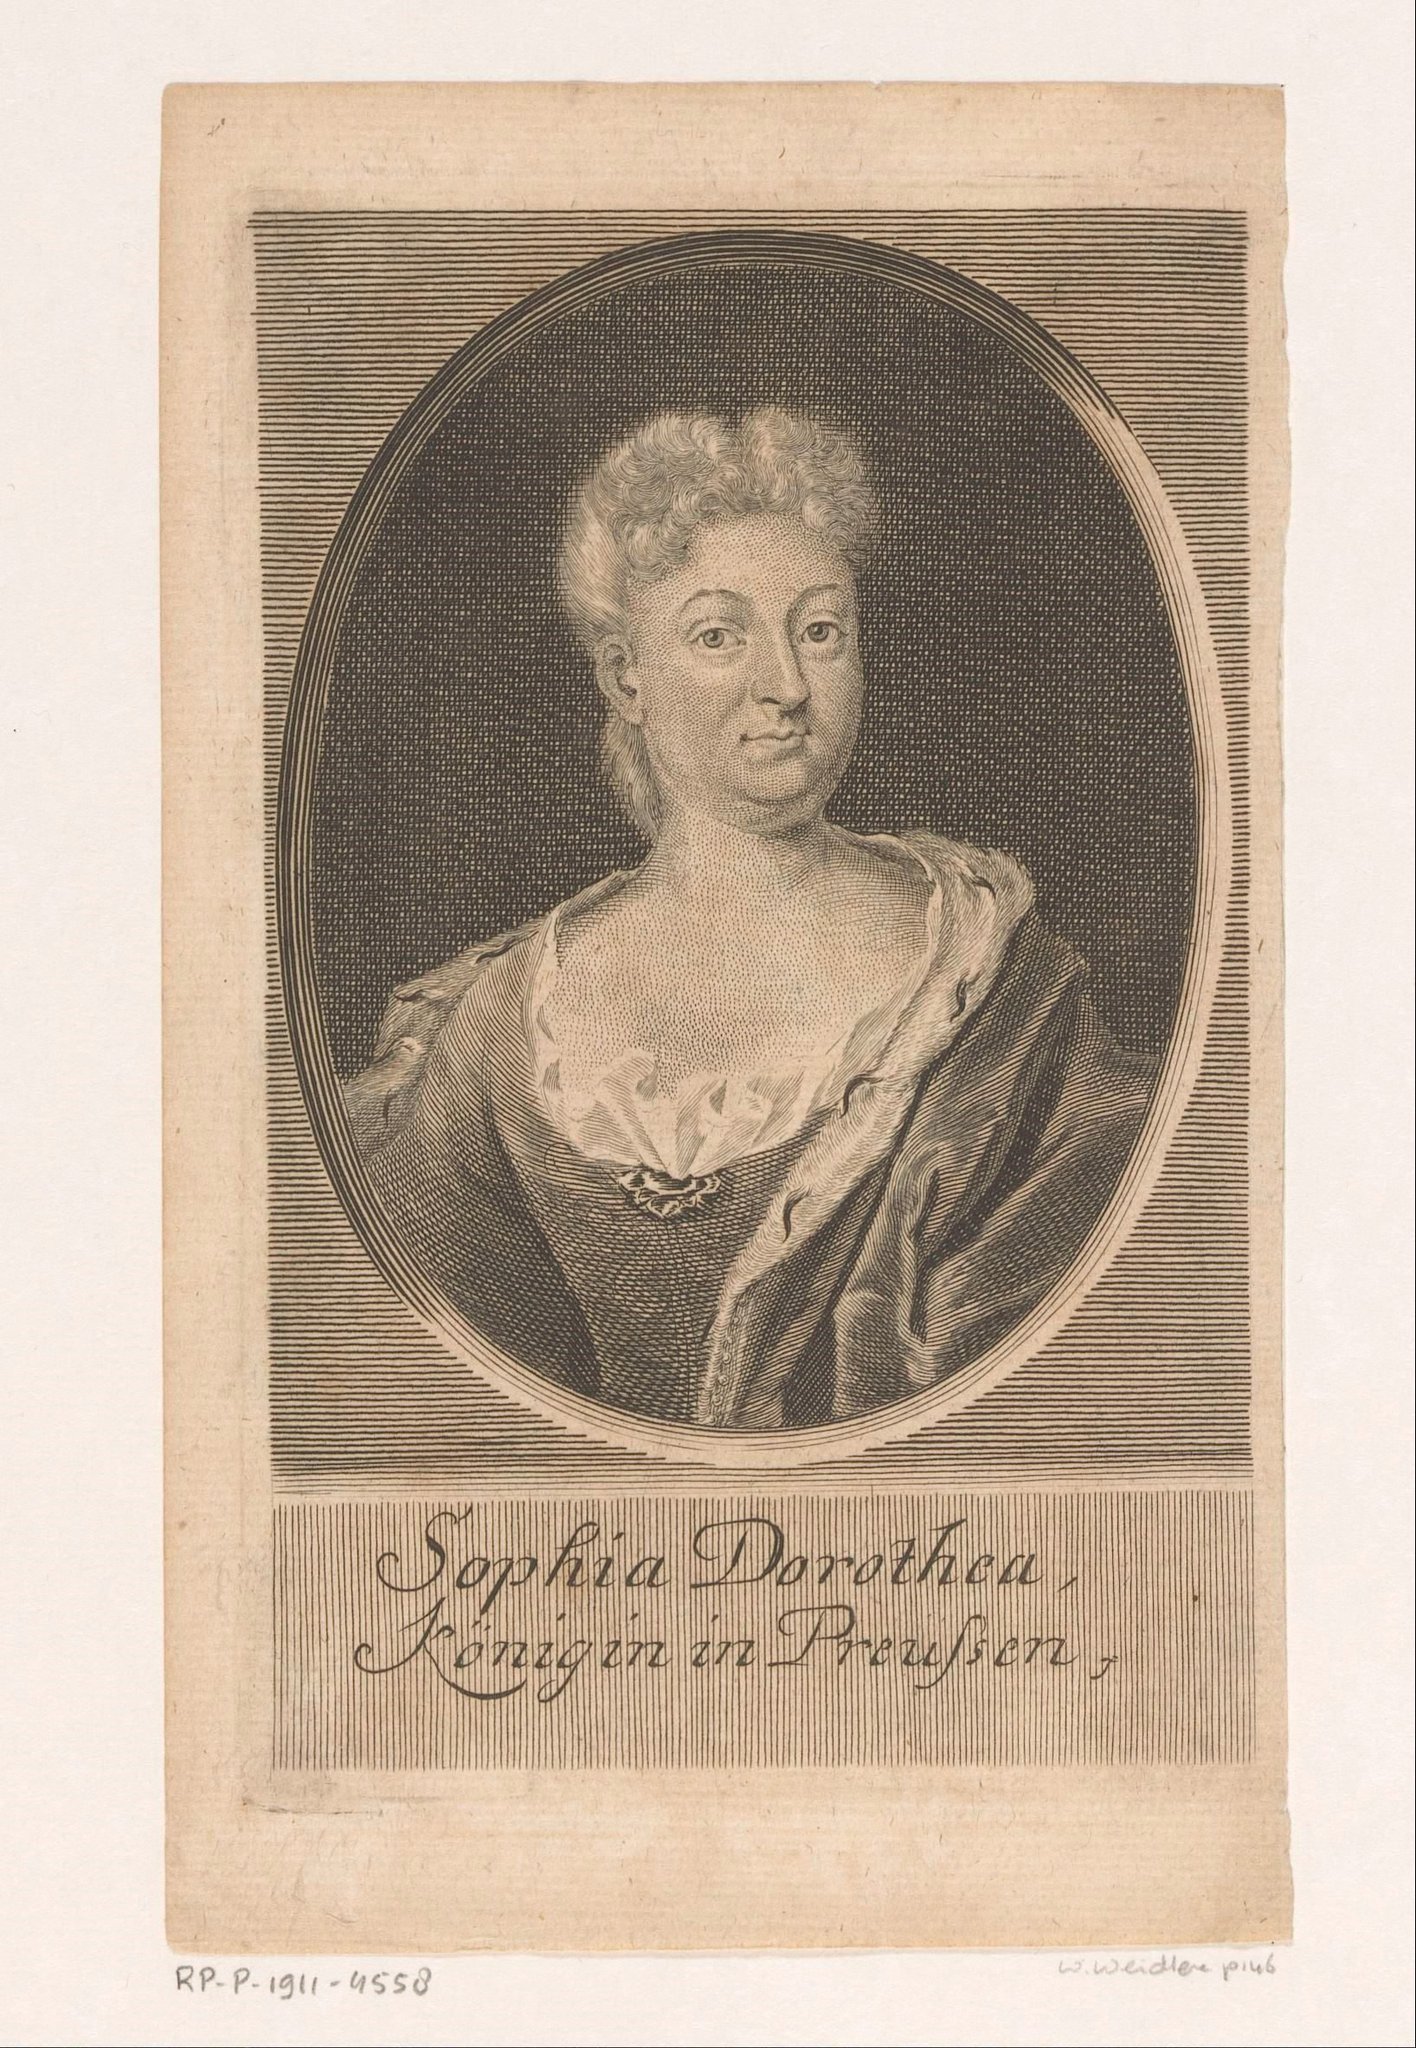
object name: print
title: Portret van Sophia Dorothea, koningin van Pruisen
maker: martin bernigeroth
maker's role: print maker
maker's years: 1670-1733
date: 1722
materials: paper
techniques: engraving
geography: leipzig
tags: berlin, historical persons - bb - woman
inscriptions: collector's mark: Lugt 2228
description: Prent ook gebruikt in: Die Europäische Fama, Welche den gegenwärtigen Zustand der vornehmsten Höfe entdecket. dl. 258. Leipzig: Gleditsch, 1722.